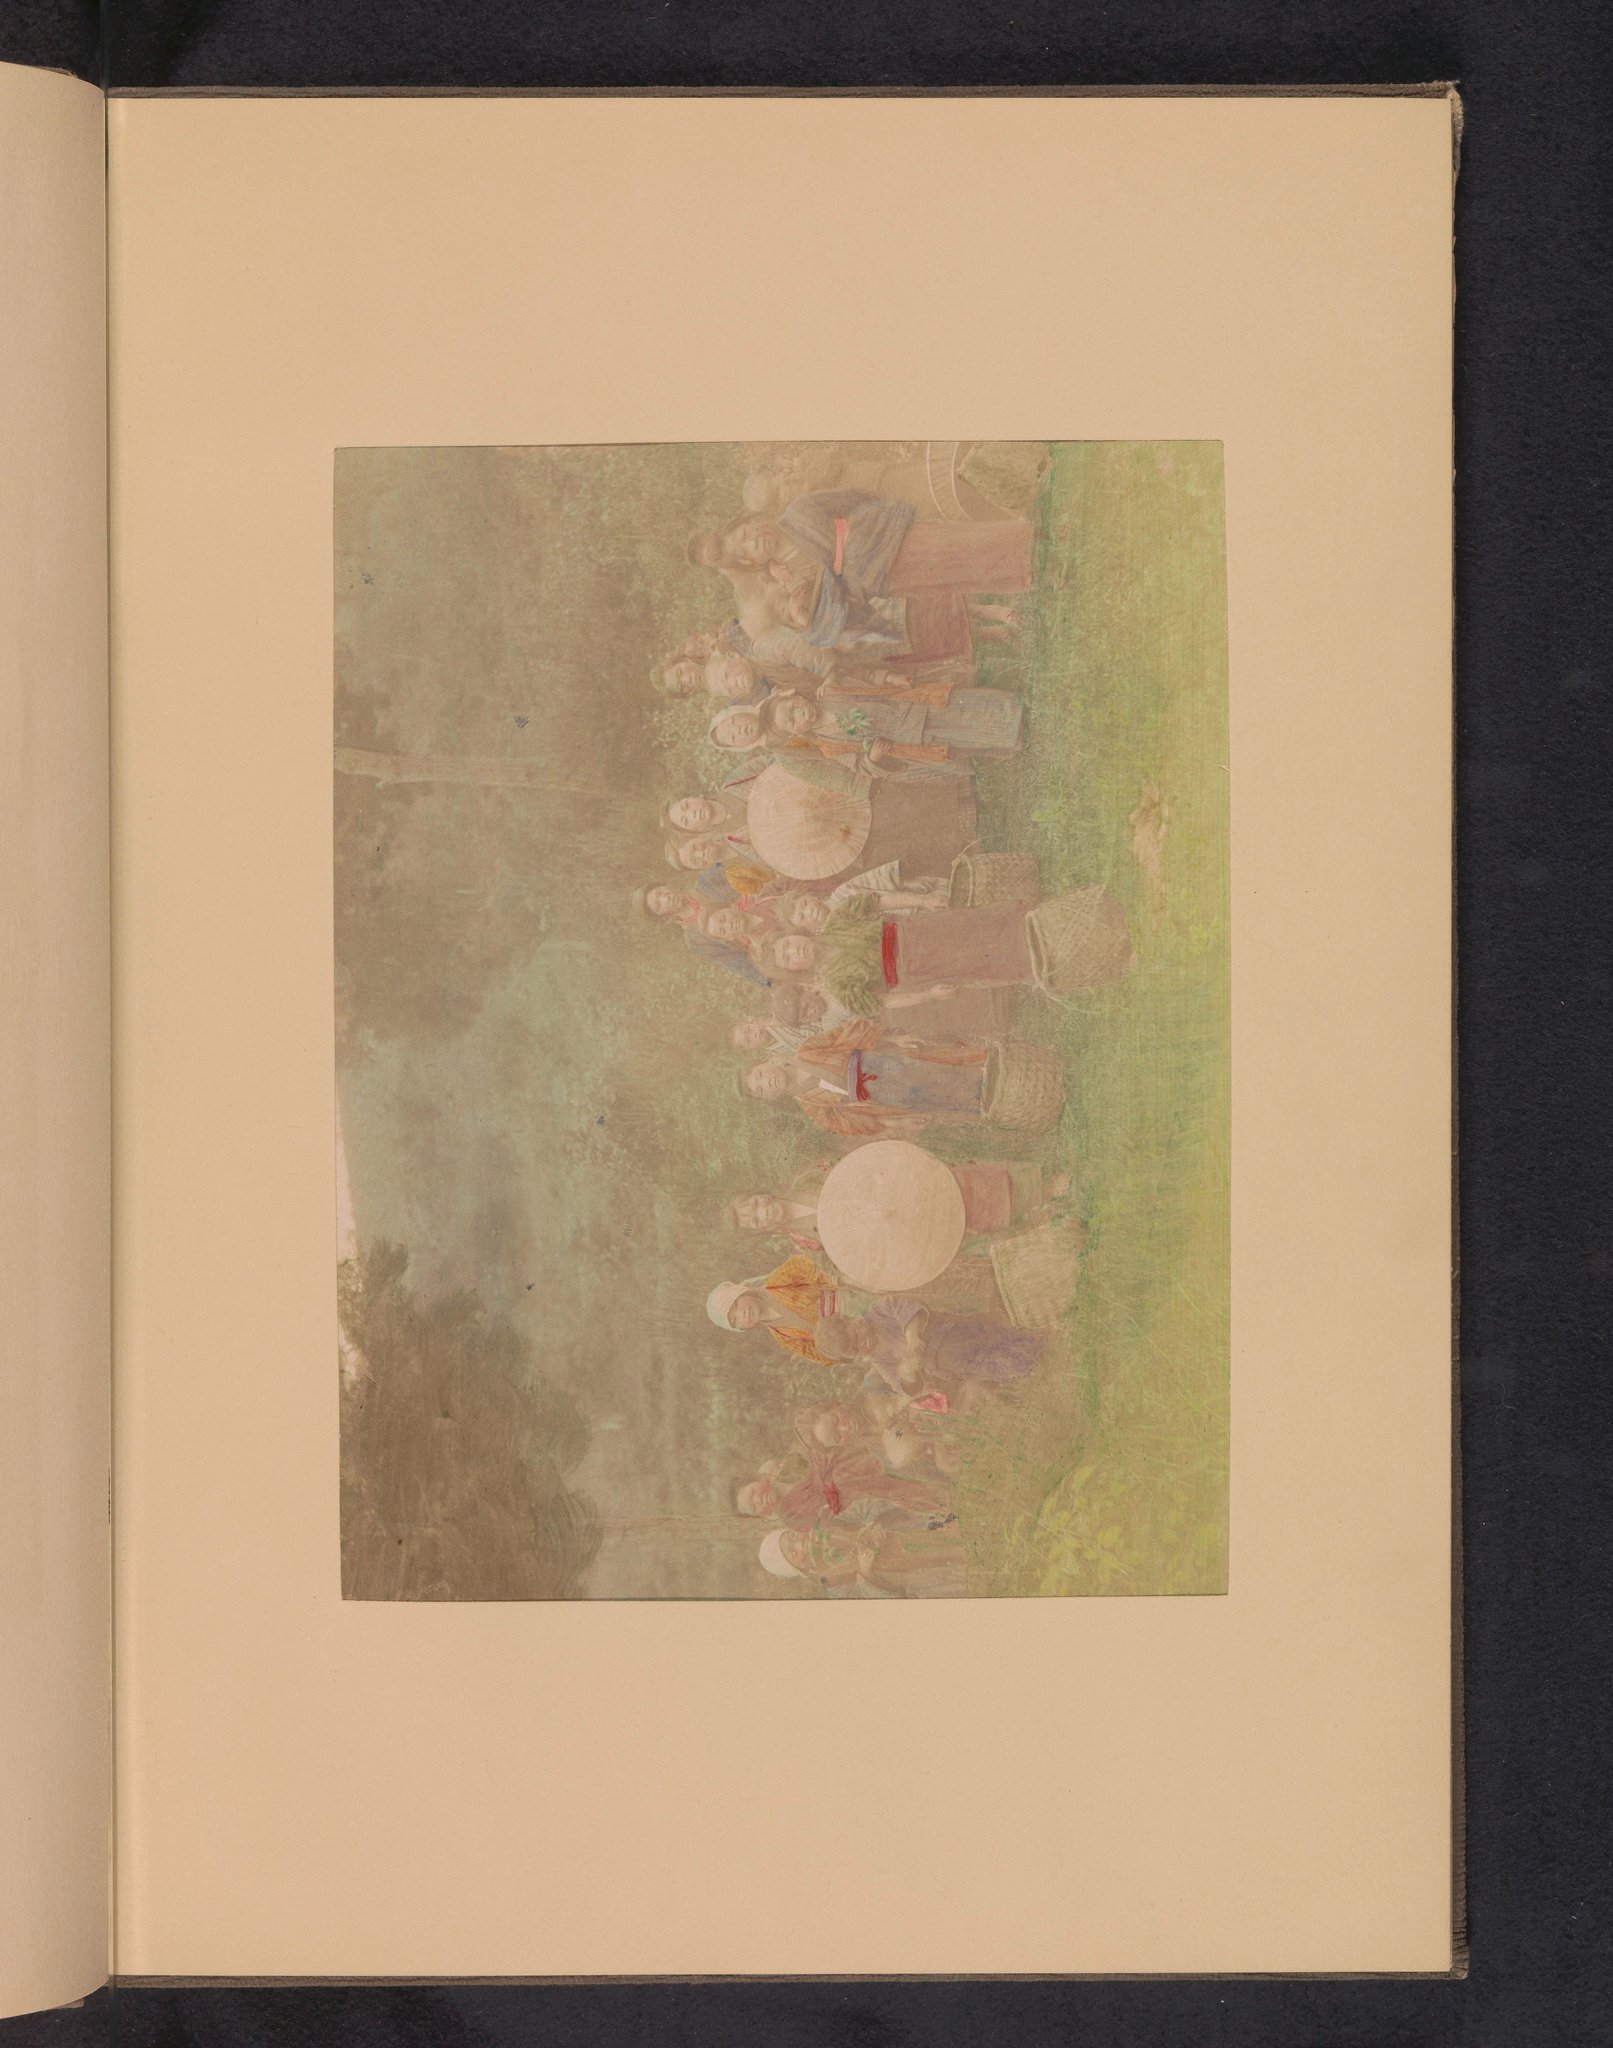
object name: page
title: Groepsportret van theeplukkers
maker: Anonymous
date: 1887-1897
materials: photographic support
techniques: albumen print, hand coloring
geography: japan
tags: child labour, working class, labourers, anonymous historical persons portrayed in a group, in a group-portrait